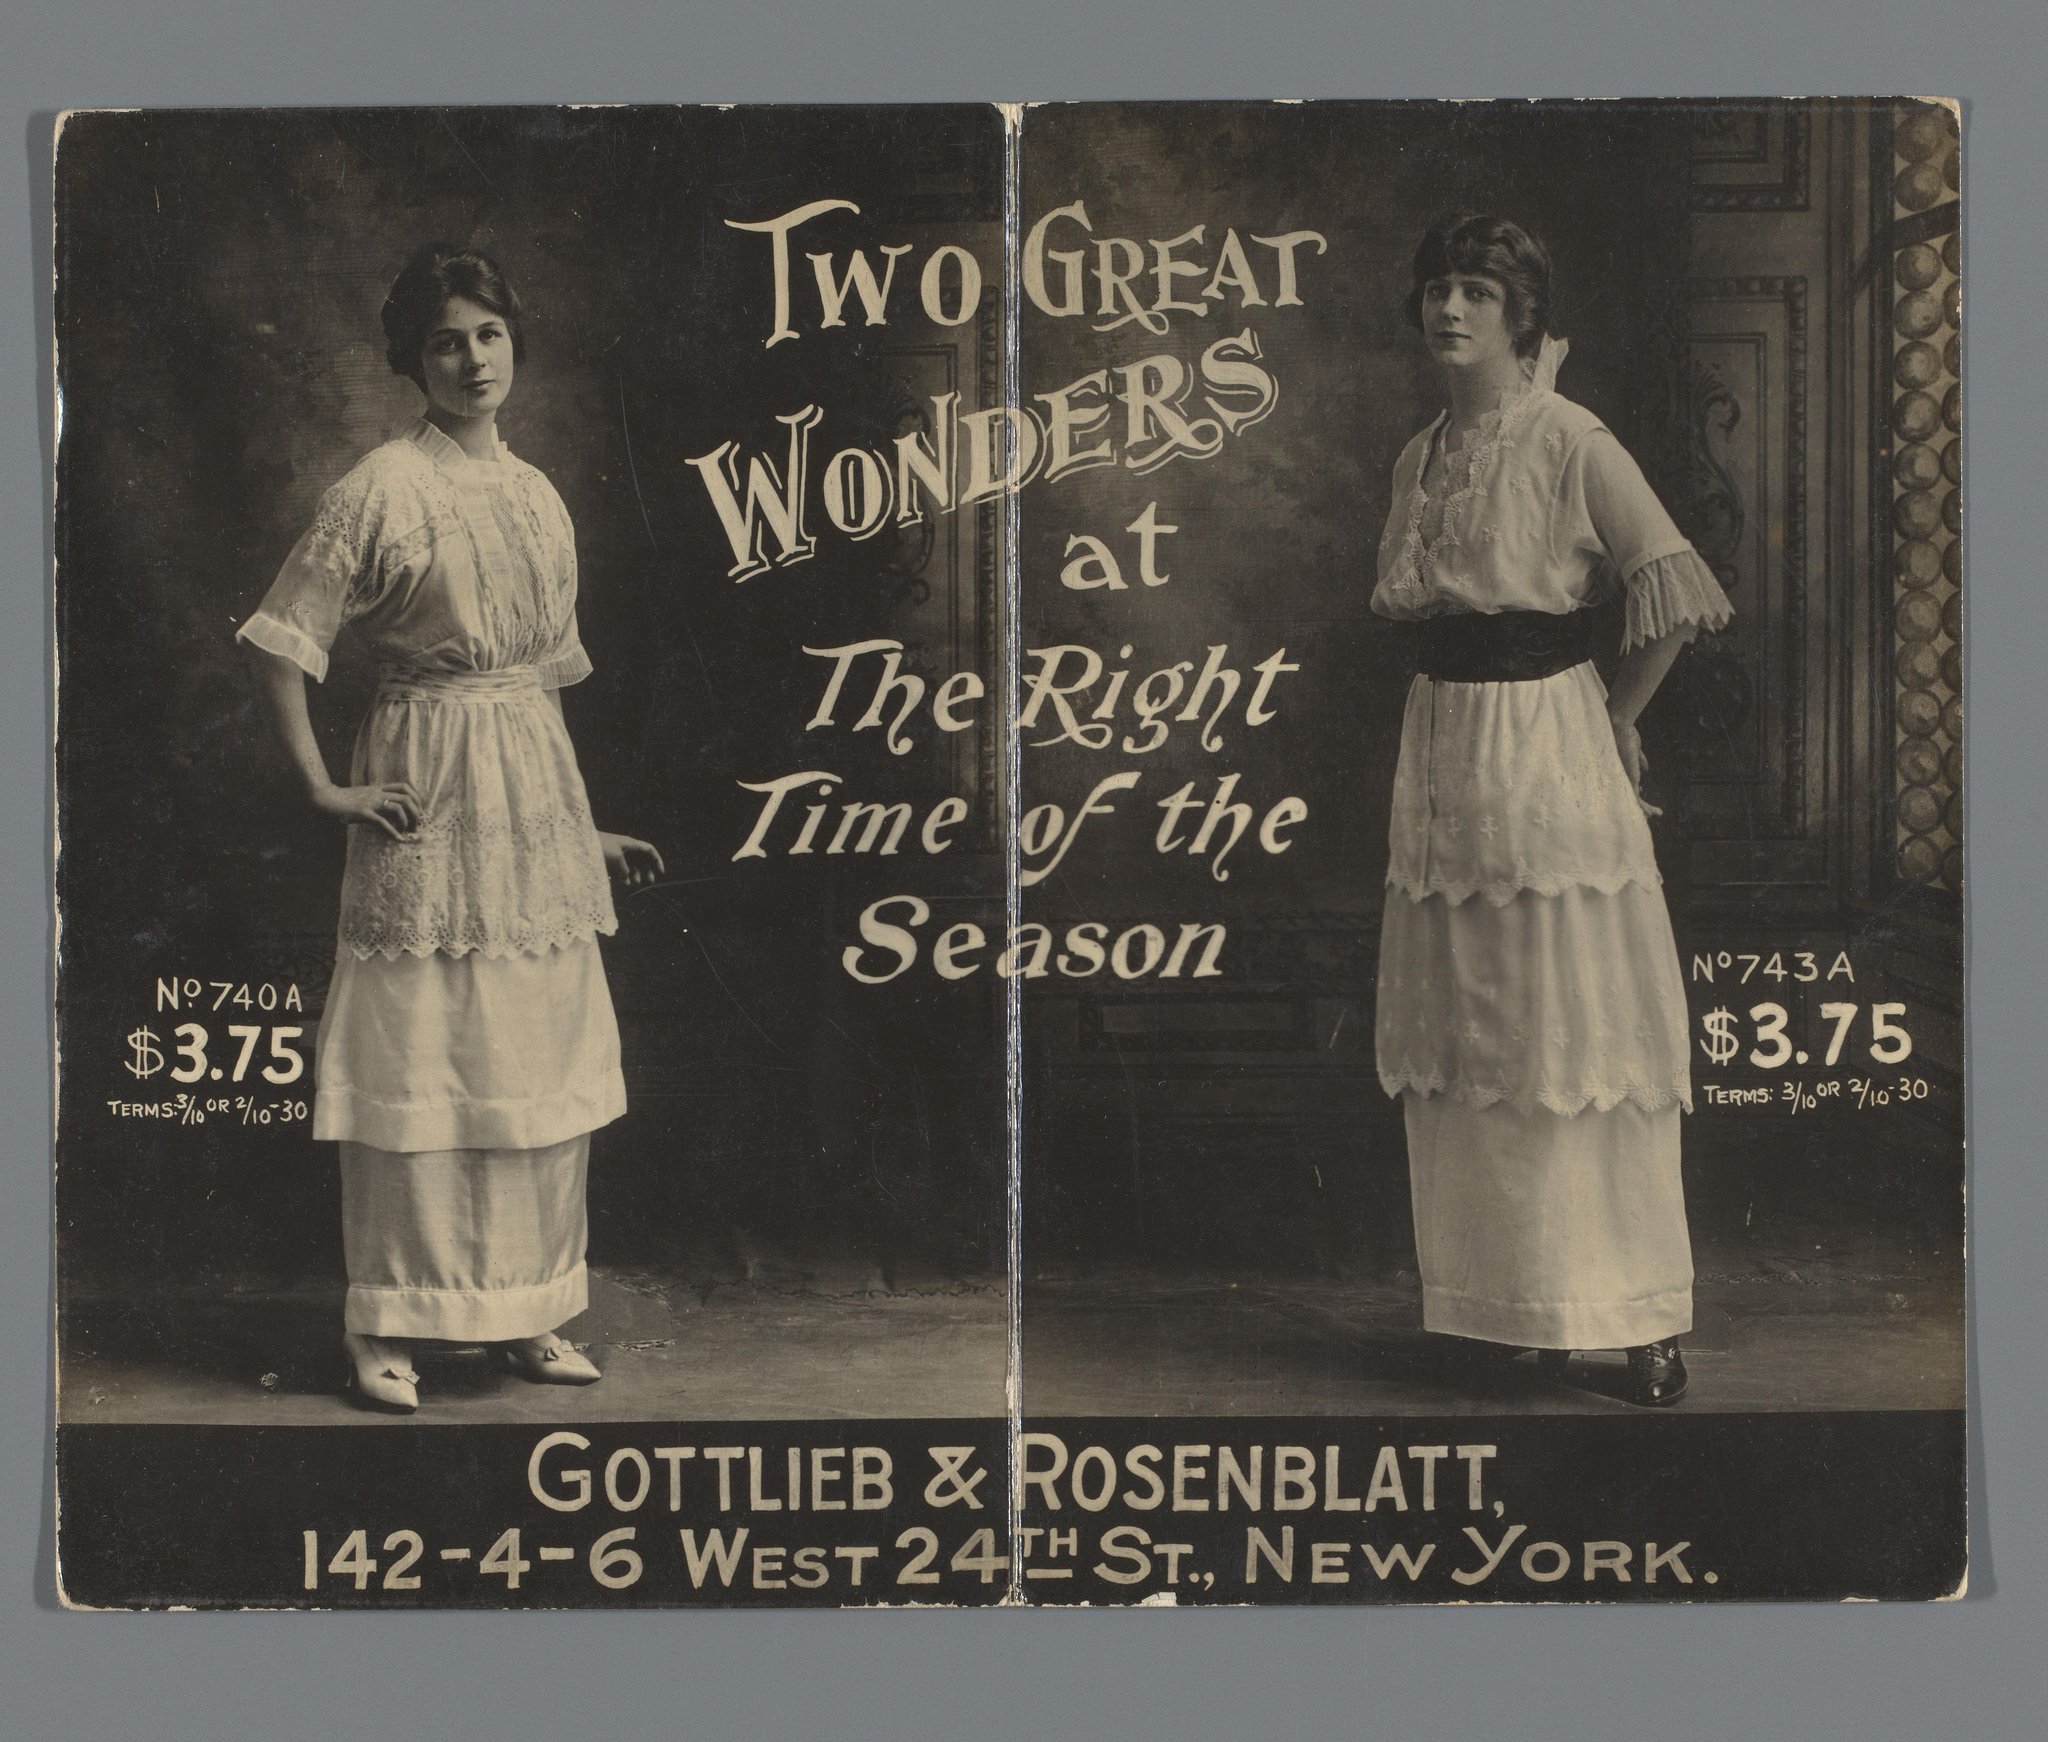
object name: ansichtkaart, prentbriefkaart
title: Tweeklapskaart met een modeadvertentie van Gottlieb & Rosenblatt (damesmode)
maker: Anonymous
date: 1914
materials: photographic support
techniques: gelatin silver print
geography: united states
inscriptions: inscription: ‘Two Great / Wonders / at / The Right / Time of the / Season / Gottlieb & Rosenblatt, / 142-4-6 West 24th St., New York. / No 740 A/ $3,75 / TERMS 3/10 or 2/10-30’, inscription: ‘Gottlieb & Rosenblatt / 142-144-146-WEST 24th STREET / NEW YORK’